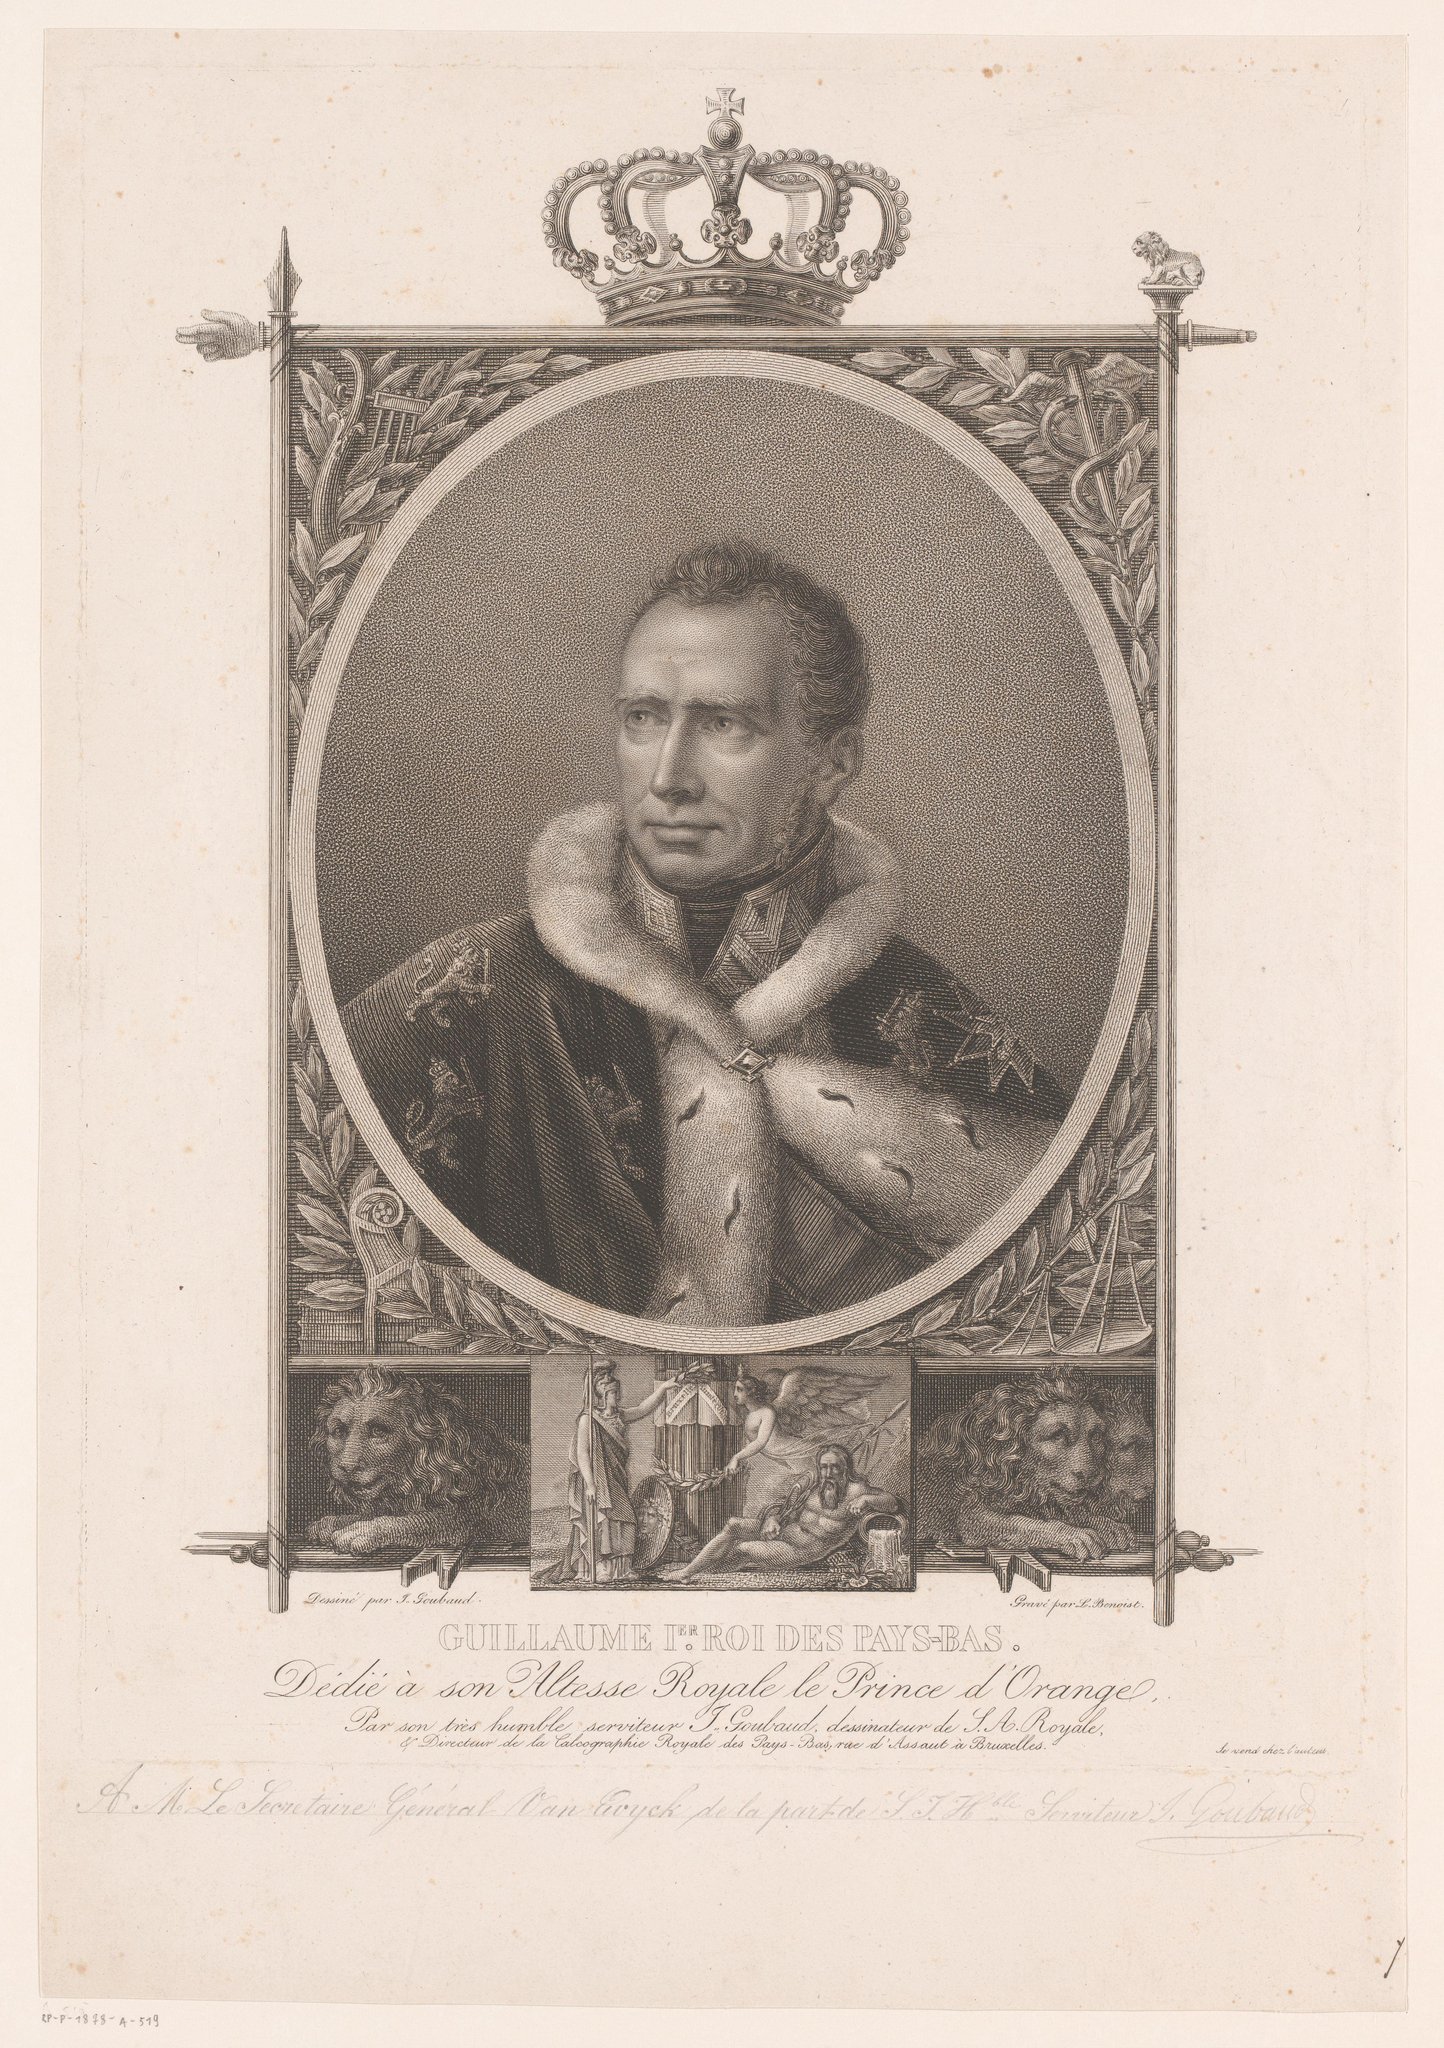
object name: print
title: Guillaume Ier. roi des Pays-Bas.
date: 1802-1815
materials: paper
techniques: etching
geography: france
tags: the hague, william i of the netherlands, lion's head ~ ornament, crown (symbol of sovereignty), ornament ~ medallion, historical persons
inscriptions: inscription: ‘A M Le Secretaire Général Van [...]yck de la part de F.I. Hble. Serviteur I. Goubard’, collector's mark: Lugt 2228